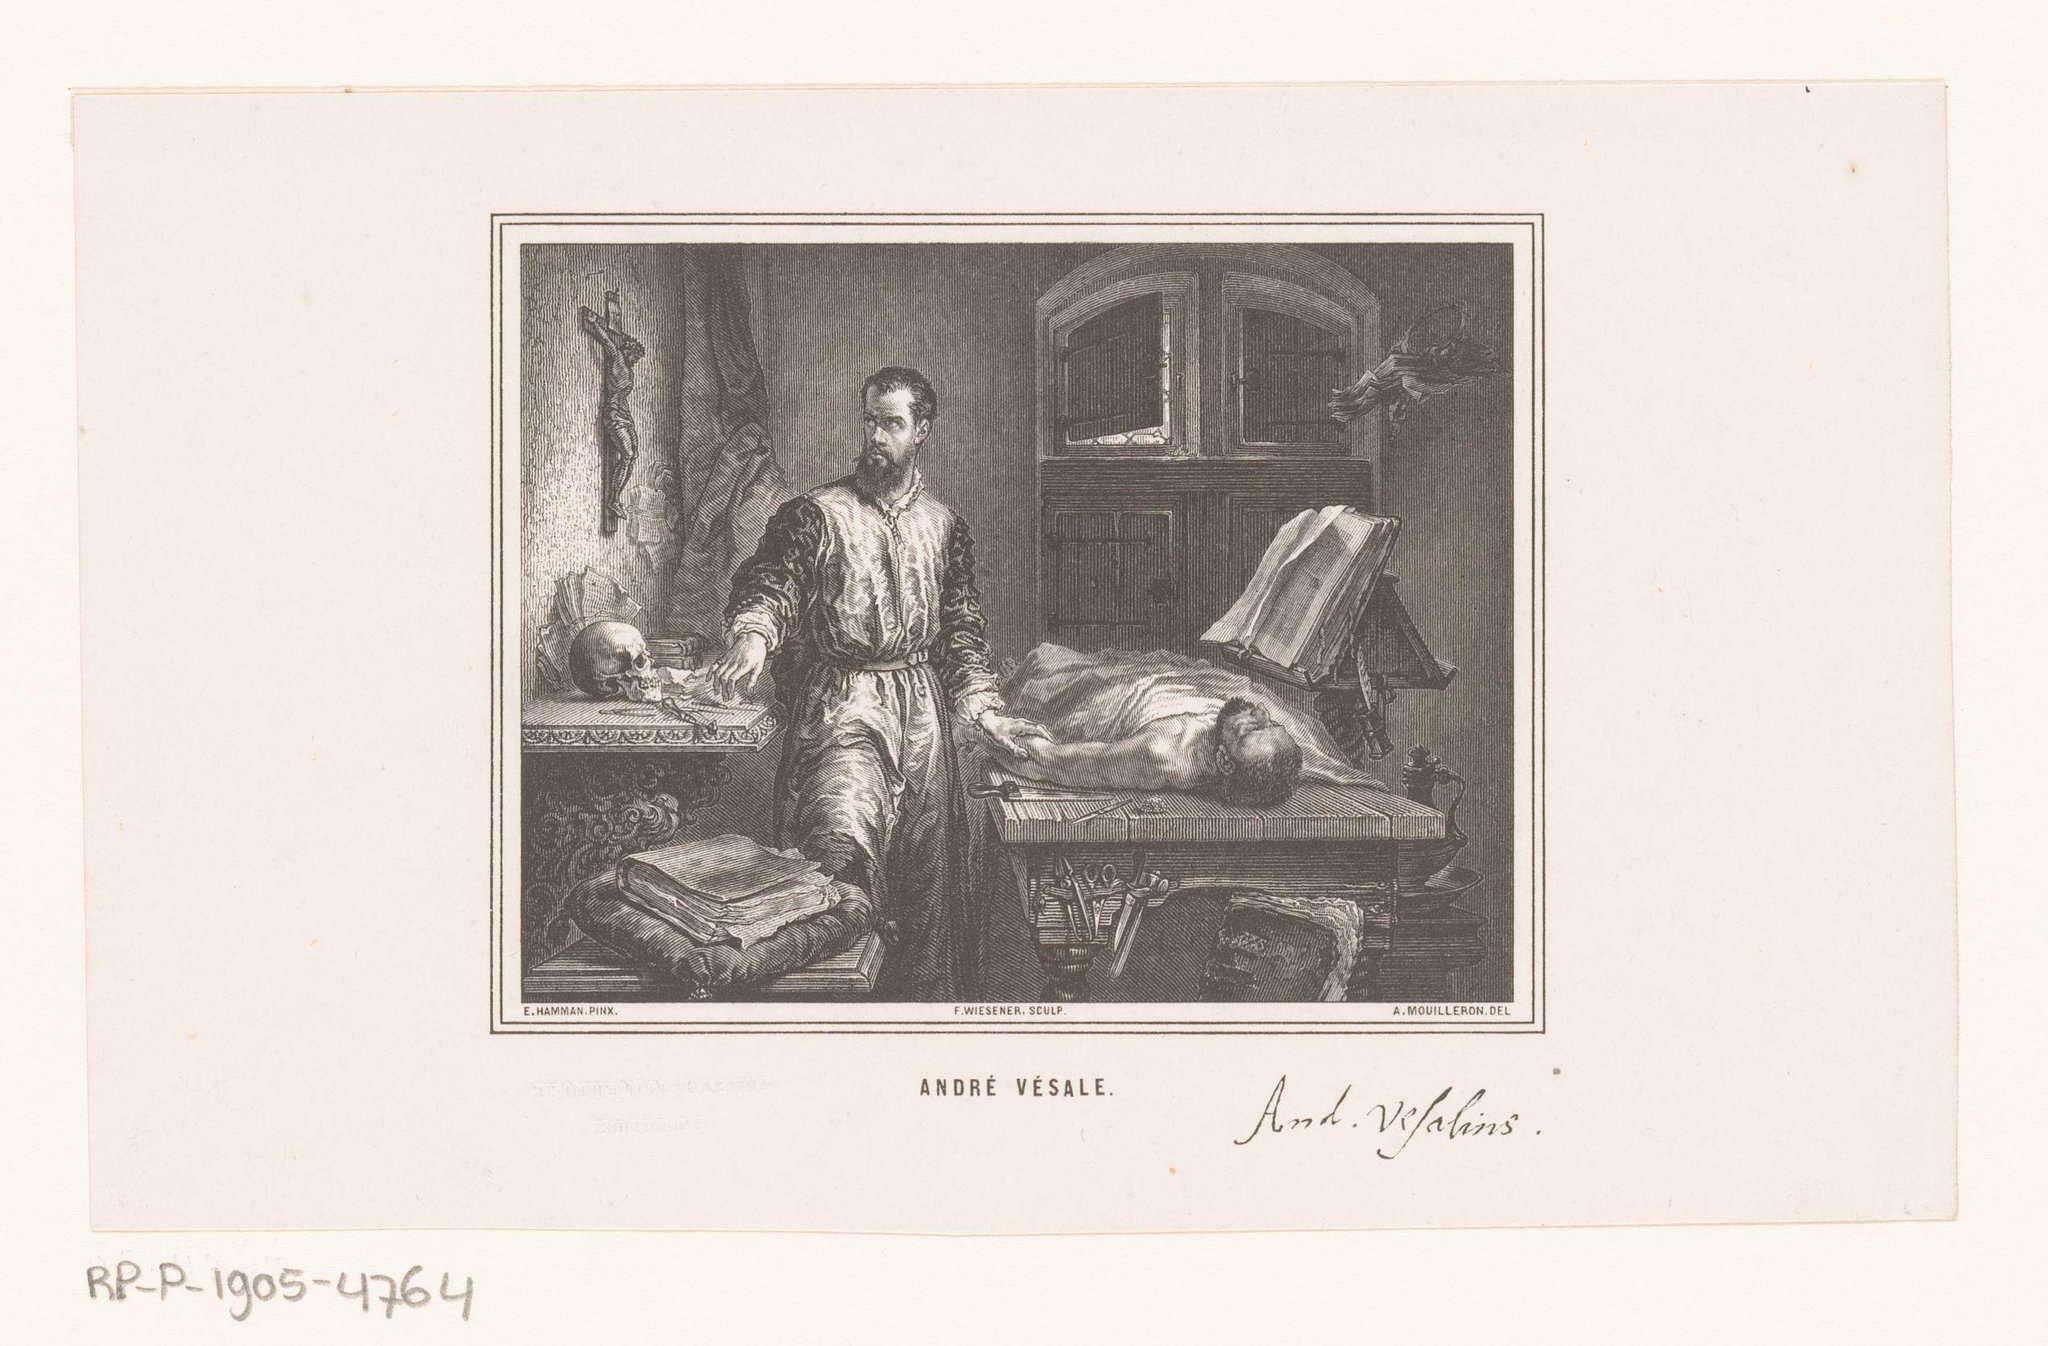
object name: print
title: André Vésale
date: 1800-1850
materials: paper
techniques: engraving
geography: paris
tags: brussels, historical persons, physician, doctor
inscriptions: check stamp: ‘Mequignon-Marvis’, collector's mark: Lugt 2228